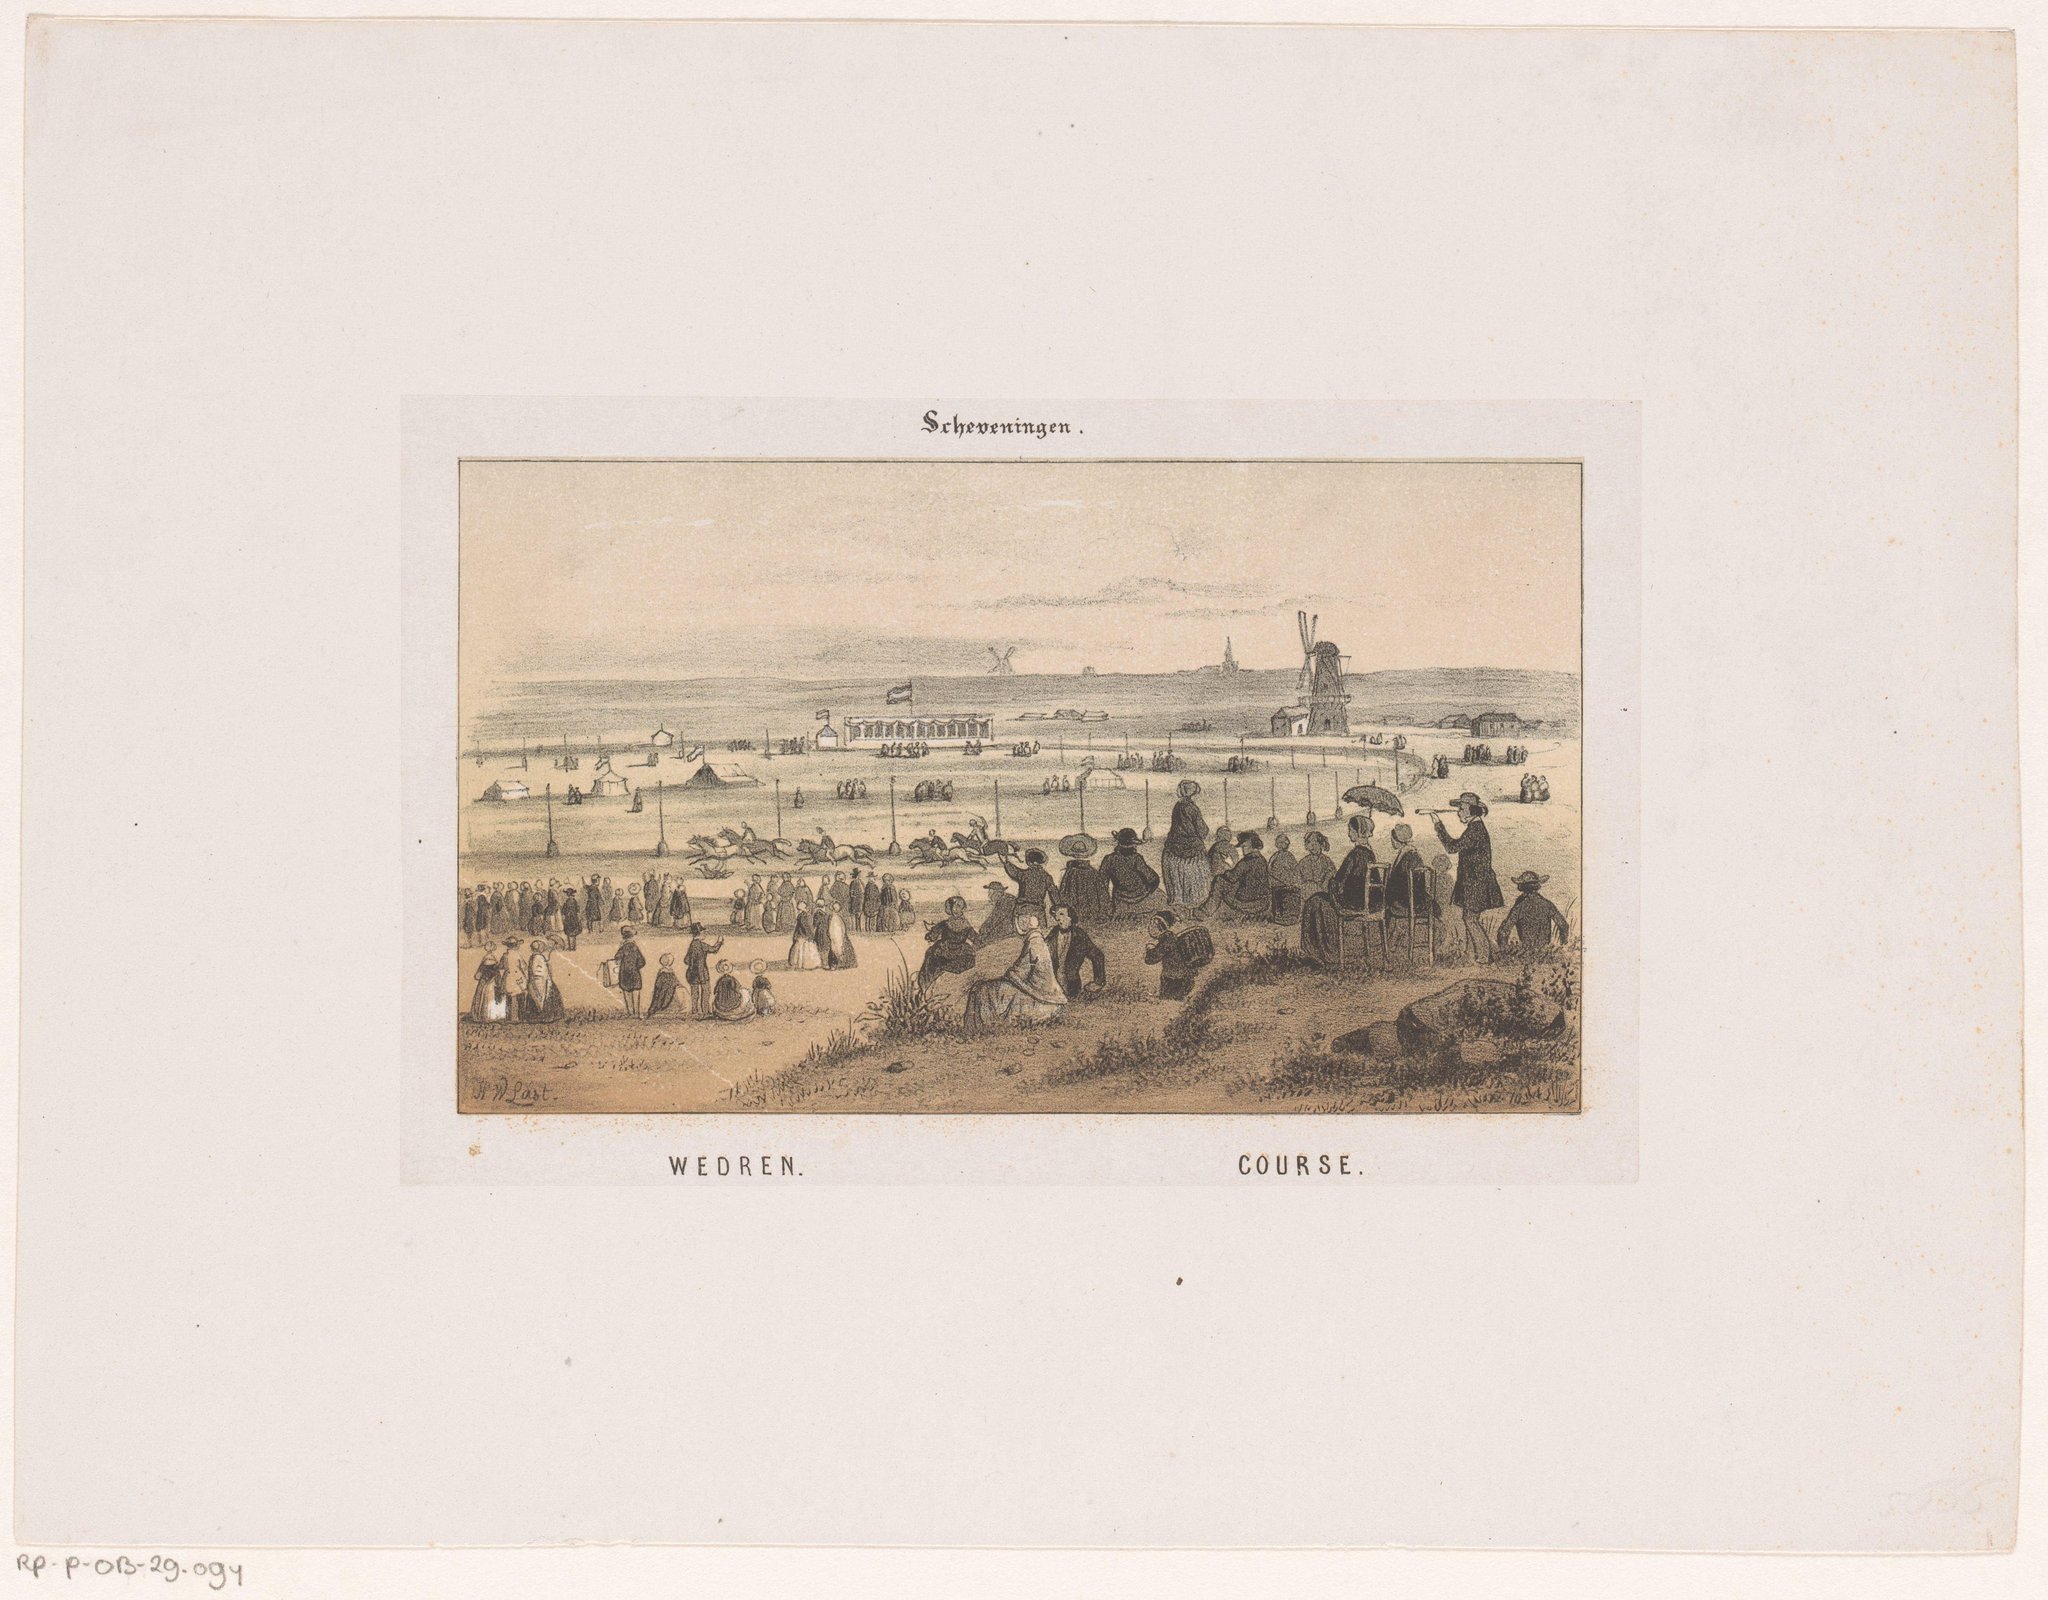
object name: print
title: Herinnering aan Scheveningen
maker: hendrik wilhelmus last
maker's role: print maker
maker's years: 1817-1873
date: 1846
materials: paper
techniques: iris print, lithograph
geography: netherlands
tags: race-track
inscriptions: collector's mark: Lugt 2228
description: Paardenrennen, een wedren gehouden te Scheveningen op 3 augustus 1846.